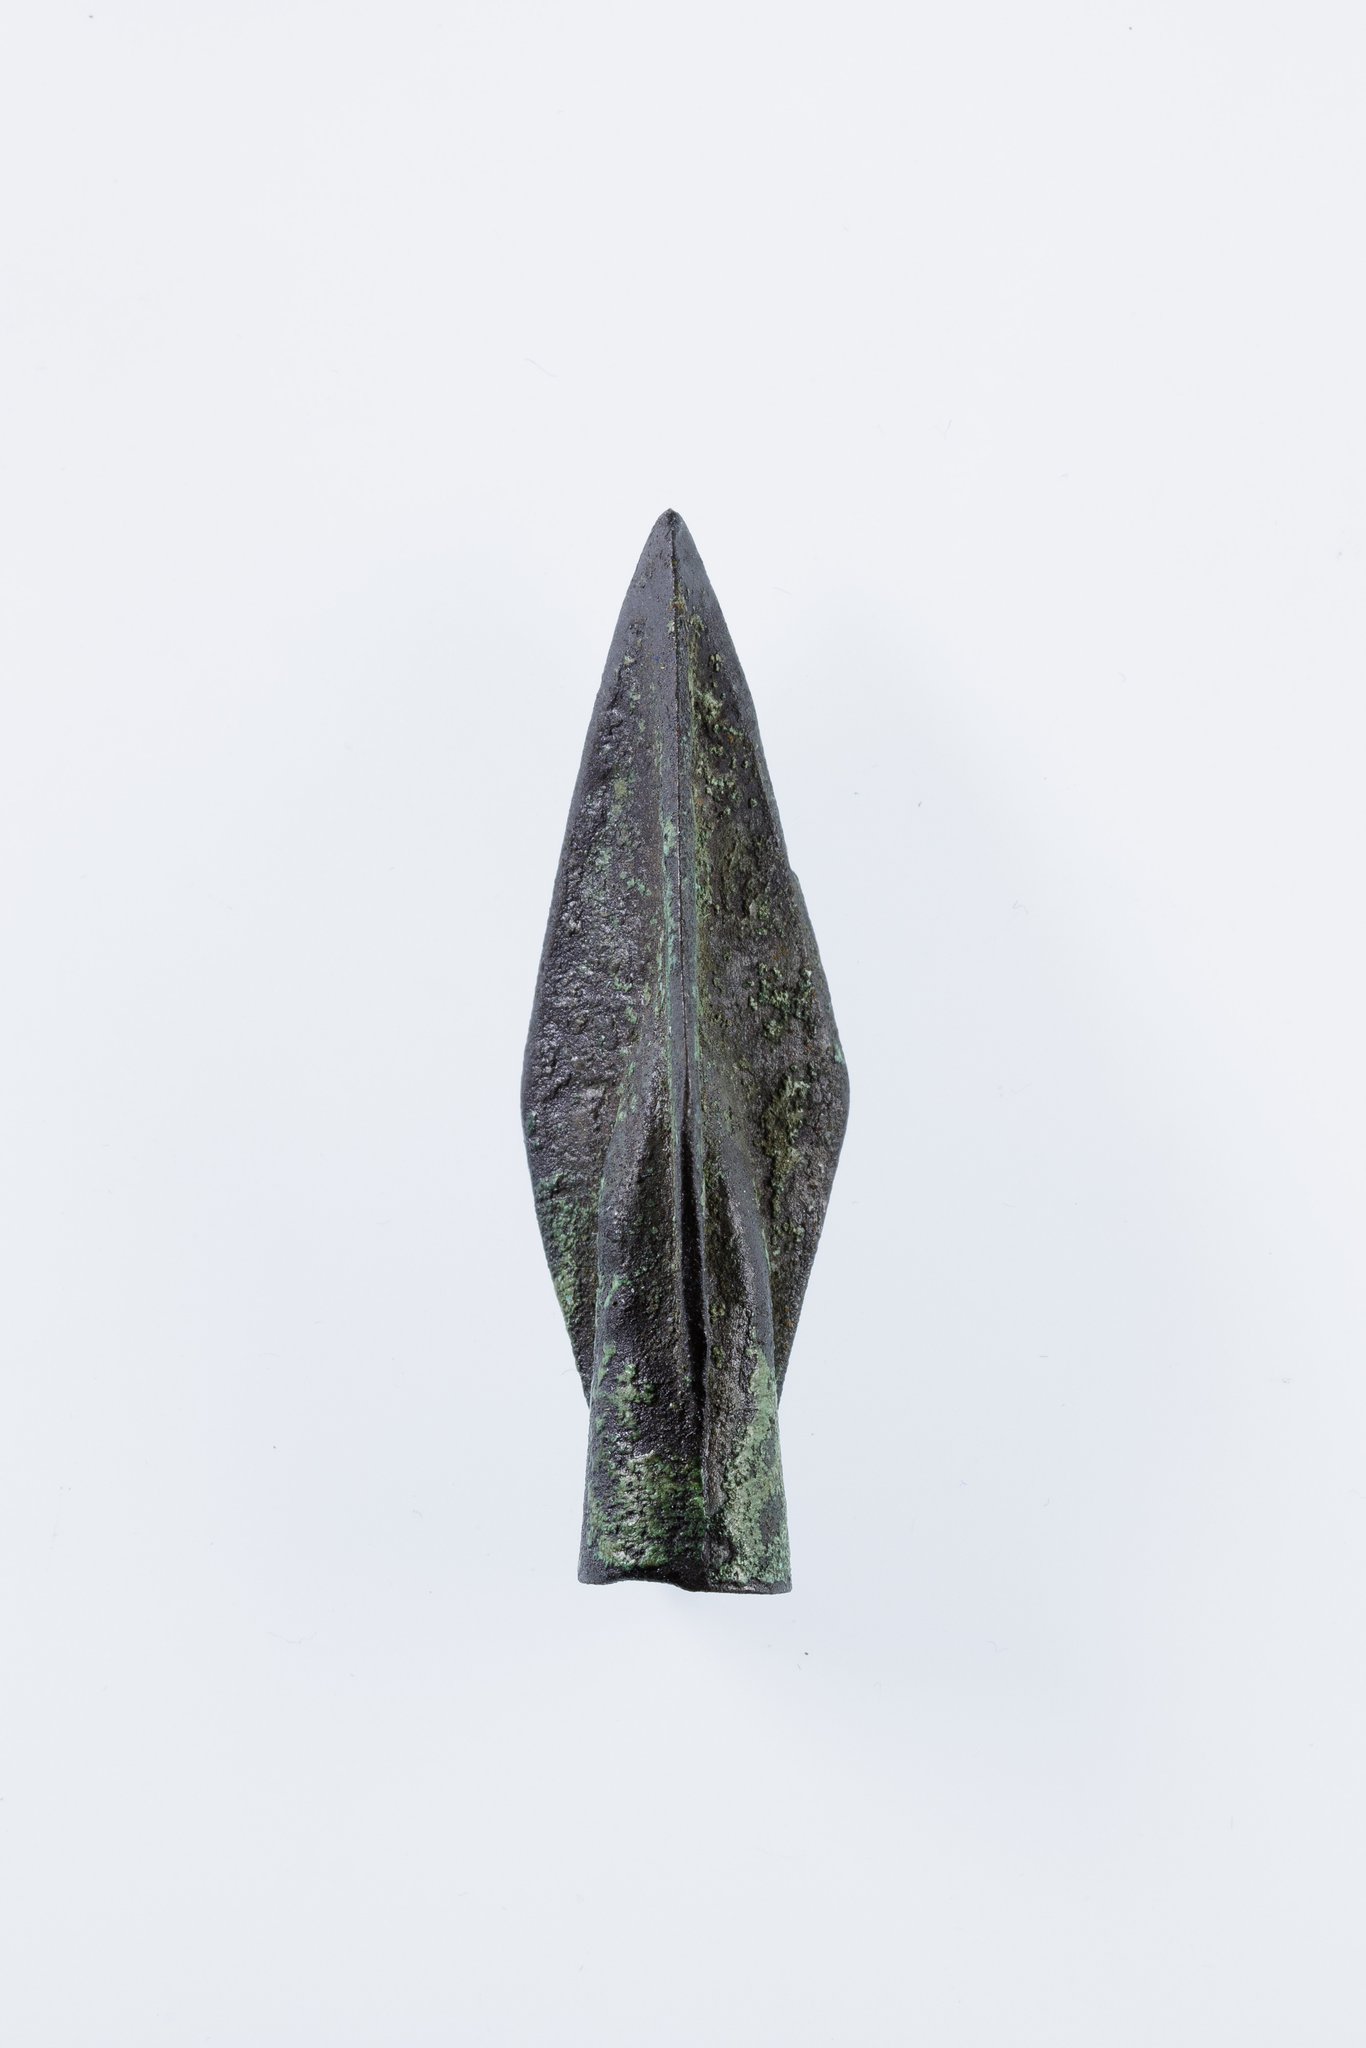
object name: arrow point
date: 664-525 BCE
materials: bronze, copper alloy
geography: egypt